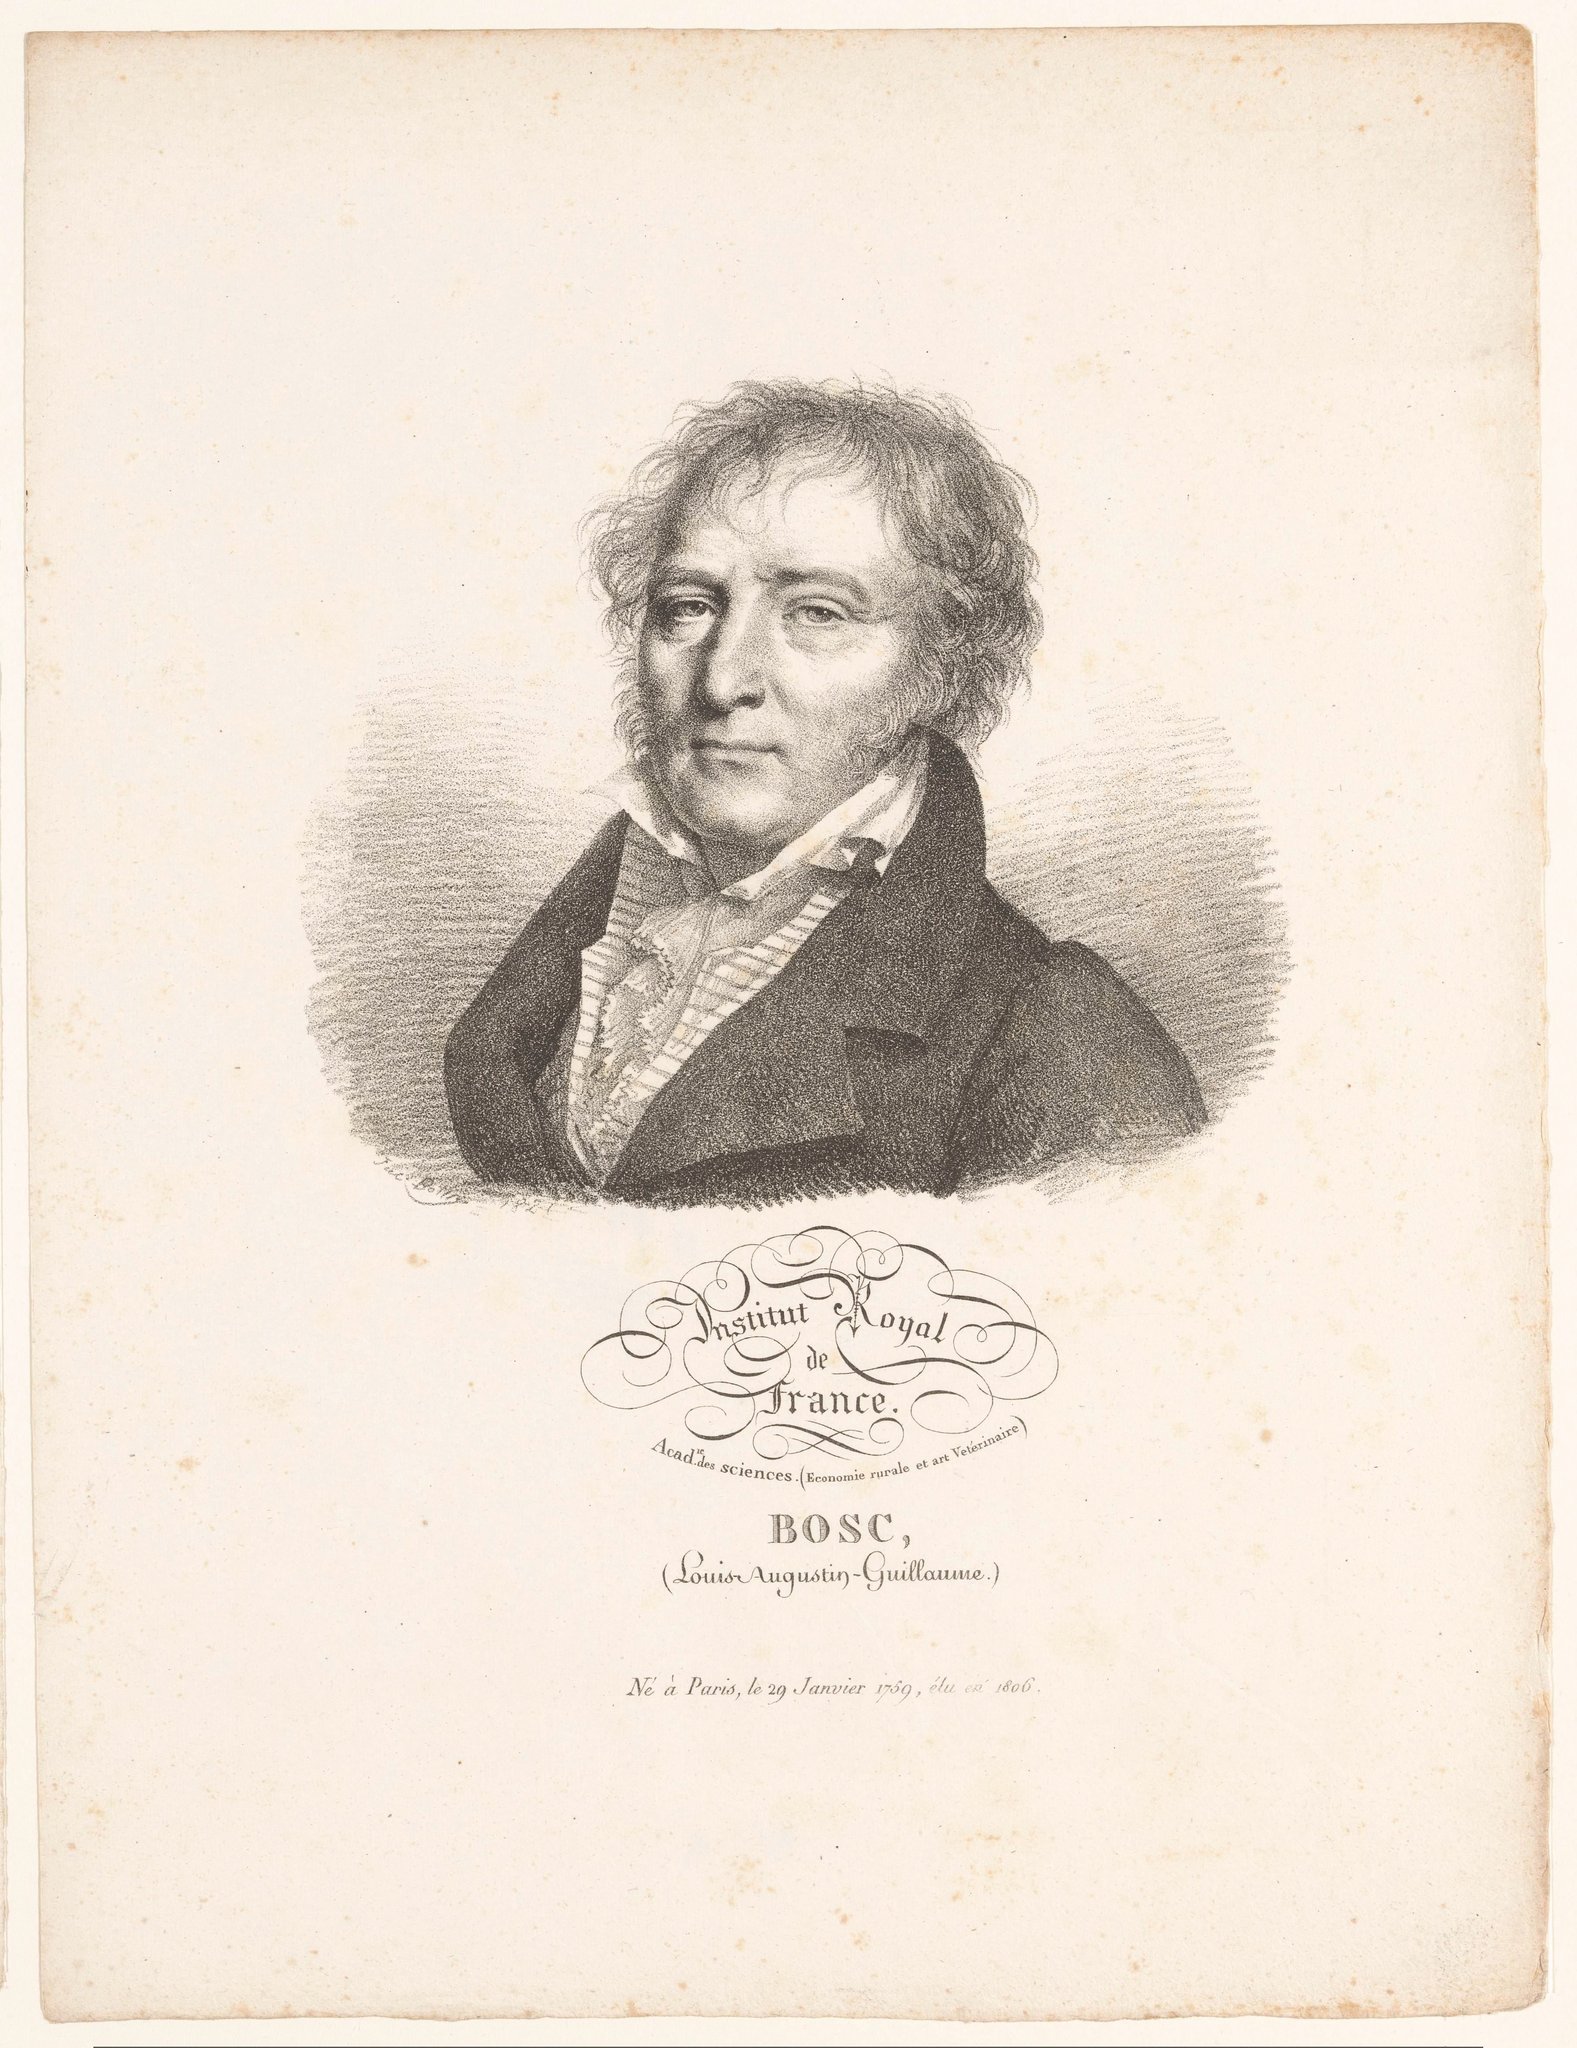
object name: print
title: Leden van het Institut Royal de France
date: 1821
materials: paper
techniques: lithograph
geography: paris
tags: paris, historical persons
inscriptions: collector's mark: Lugt 2228a